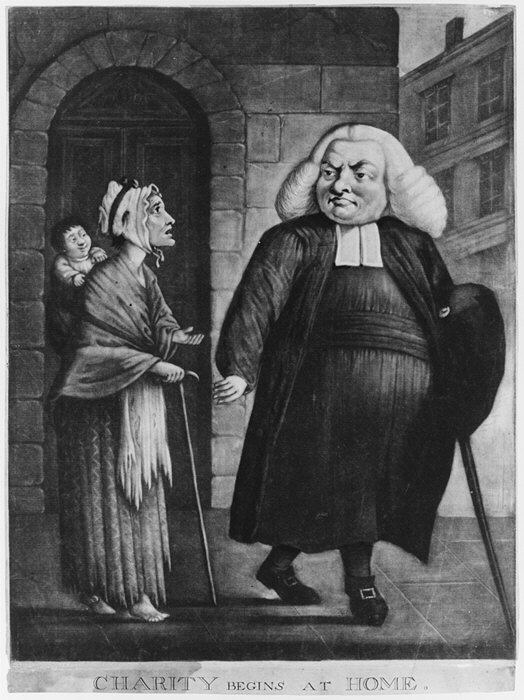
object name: print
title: Charity Begins at Home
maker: anonymous, british, 18th century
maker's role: artist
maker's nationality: british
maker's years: 1700-1800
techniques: hand coloring, mezzotint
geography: england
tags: infants,men,women